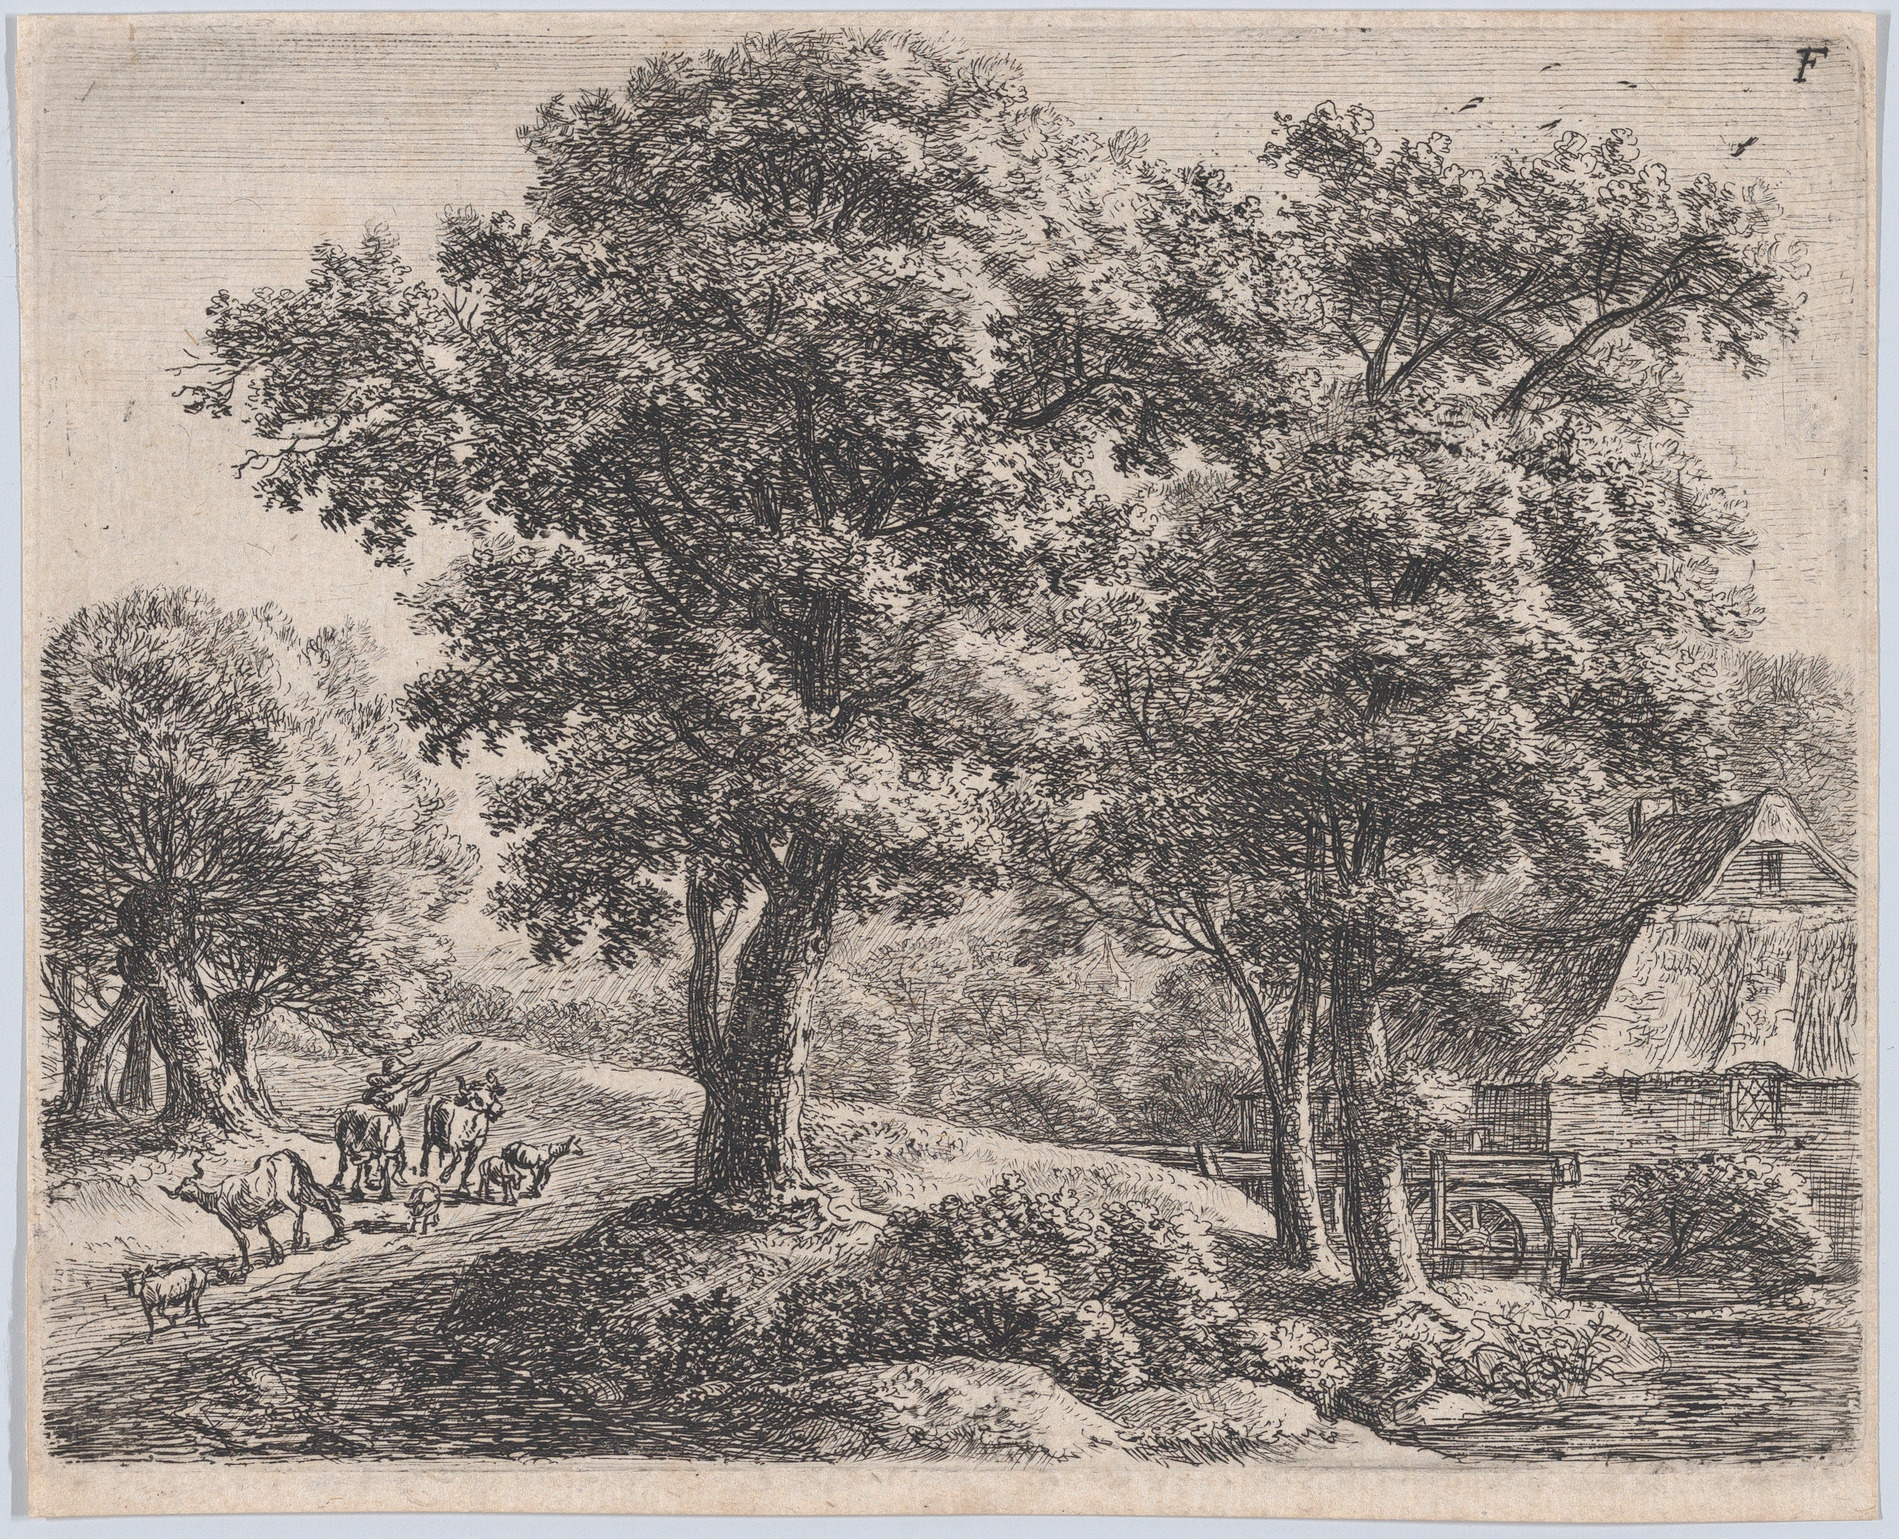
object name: print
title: The Herdsman and the Mill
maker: anthonie waterloo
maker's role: artist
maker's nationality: dutch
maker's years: 1609-1690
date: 1601-1700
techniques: etching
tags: animals,buildings,men,trees